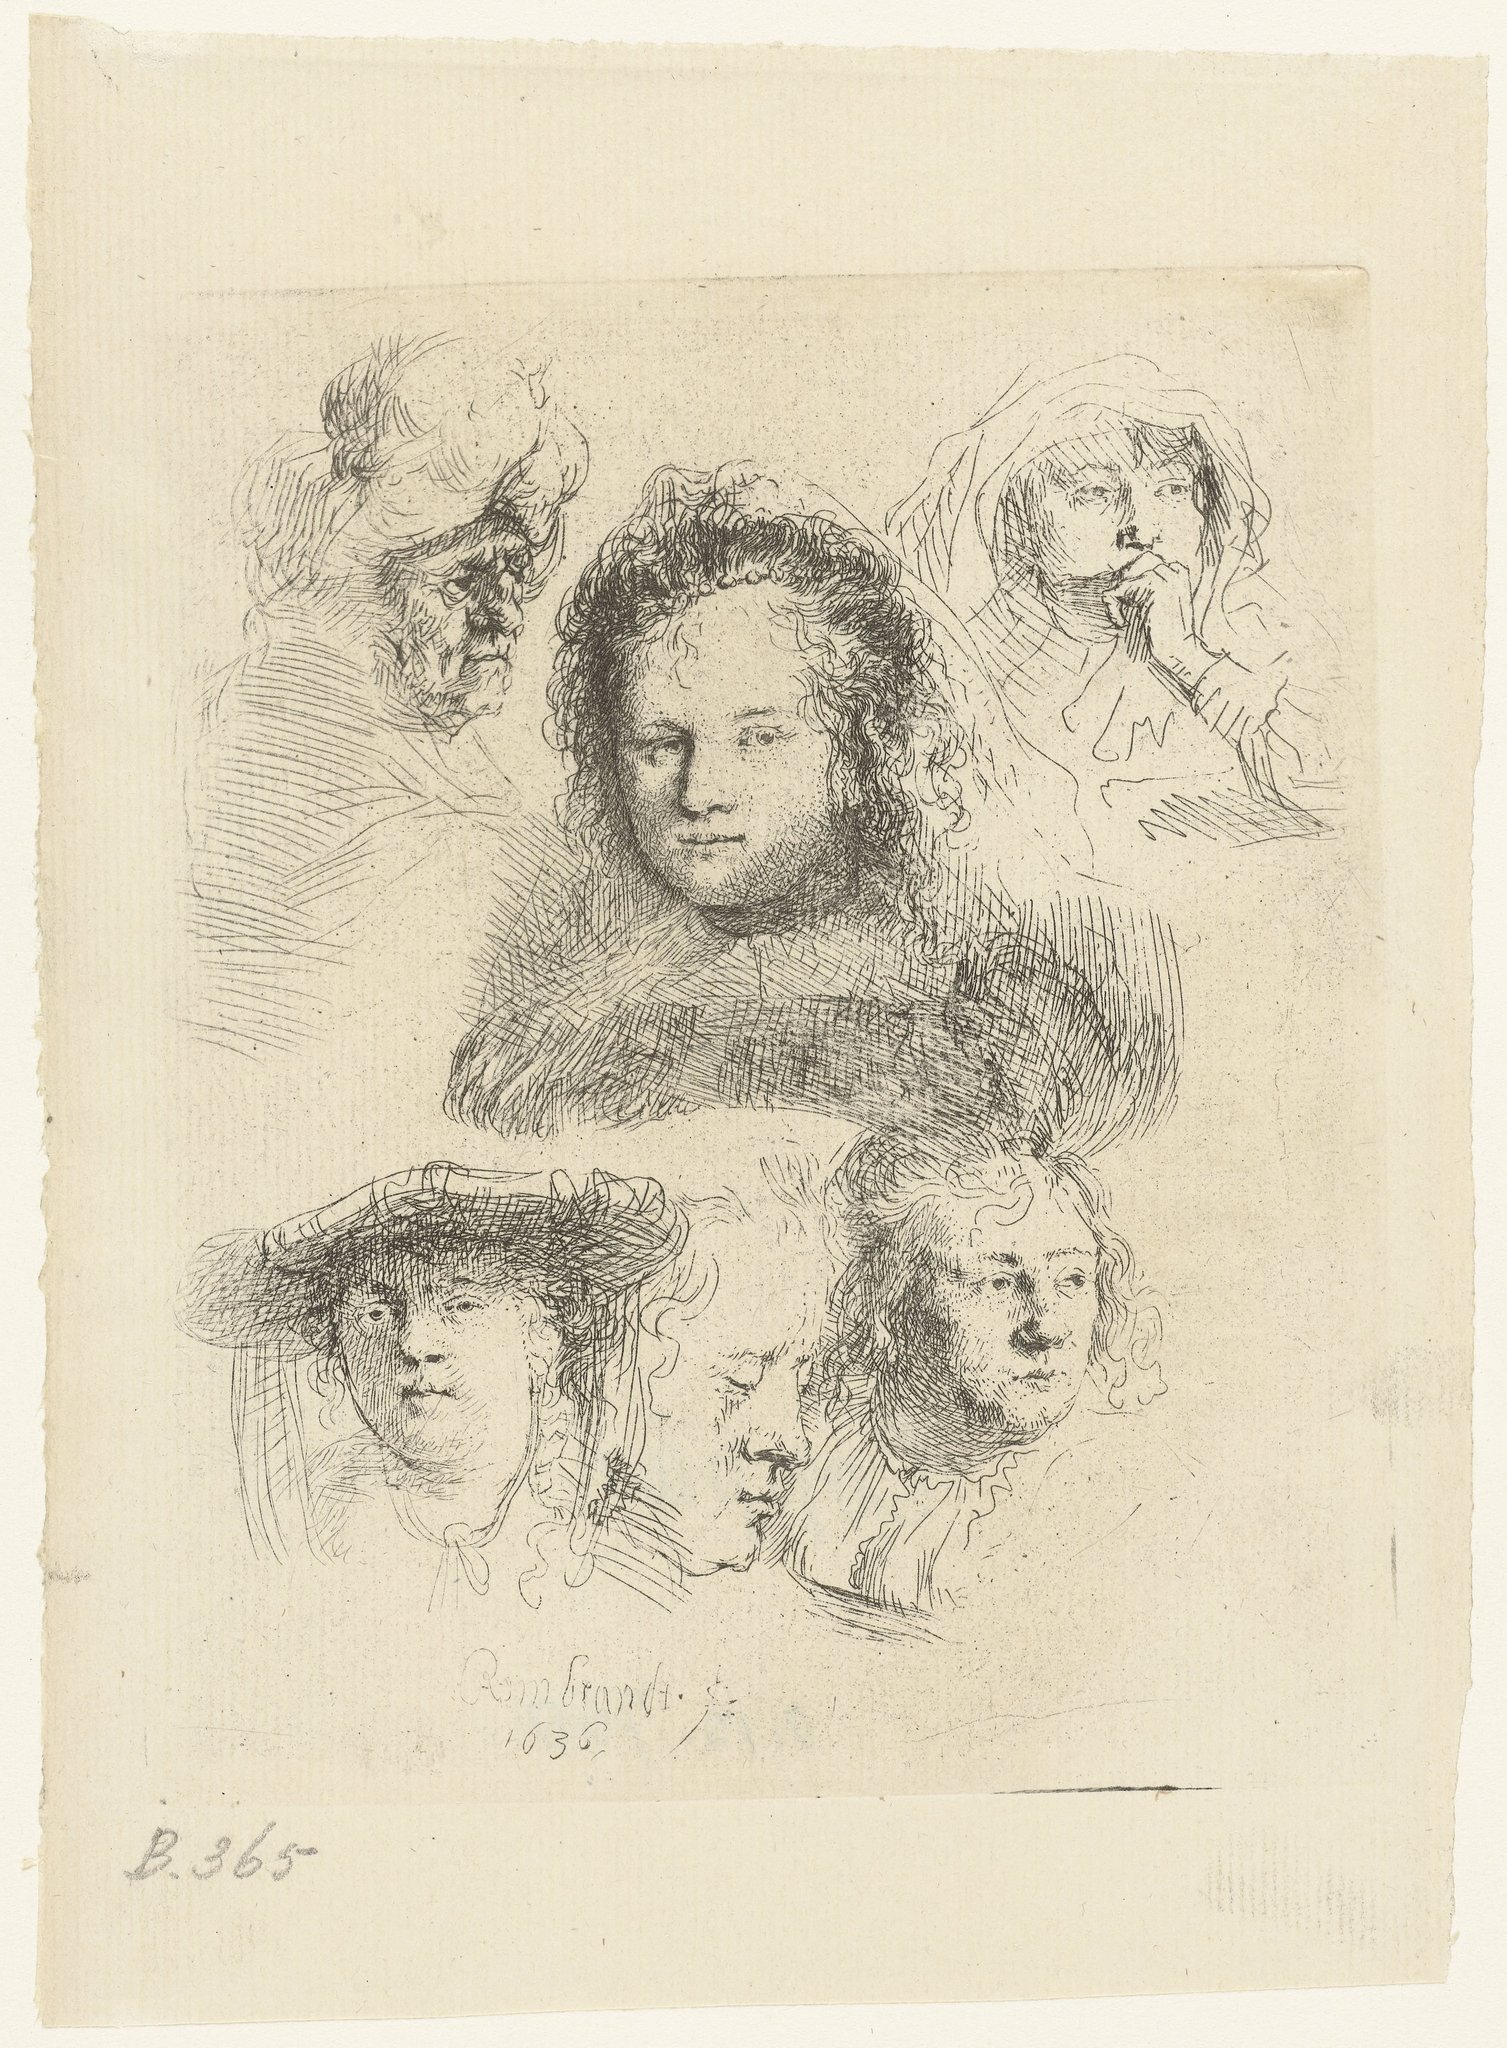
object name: print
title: Studies of the head of Saskia and others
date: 1636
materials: paper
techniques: etching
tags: amsterdam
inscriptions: inscription: ‘Coppier’, signature and date: ‘Rembrandt f. 1636’